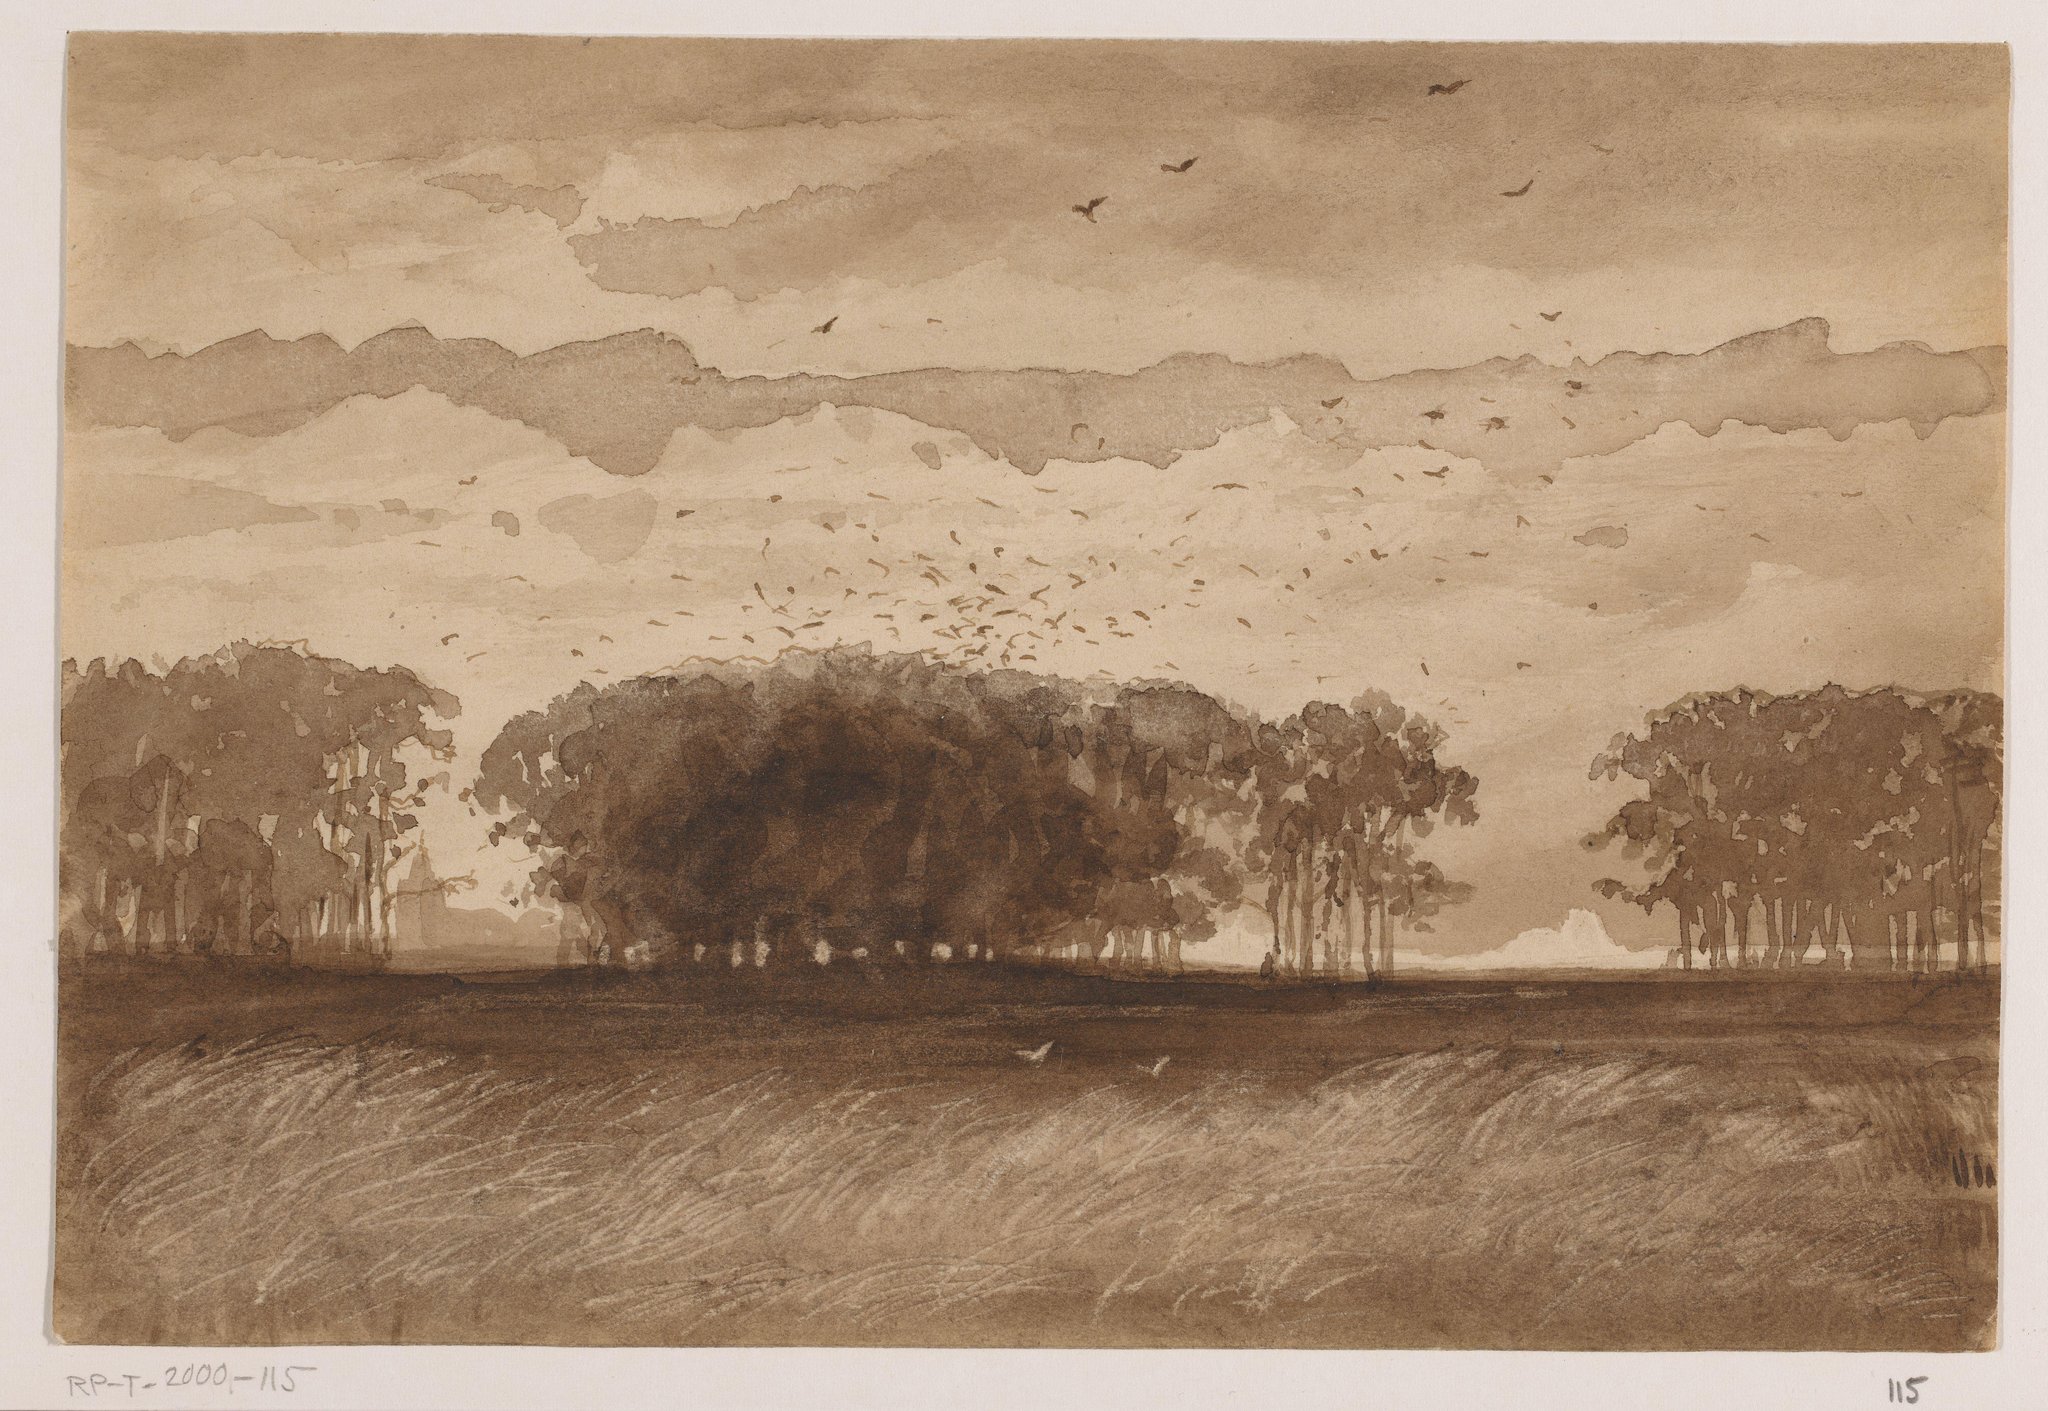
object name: drawing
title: Roekenkolonie in Noord-Brabant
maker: johannes tavenraat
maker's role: draughtsman, painter, print maker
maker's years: 1809-1881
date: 1842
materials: ink, paper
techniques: brush, pen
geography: ardennen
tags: song-birds: rook, groups of trees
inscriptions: annotation: ‘a Rookery on moorgroungs in North Brabant - Antwerp - 1842 - Tavenraat’, collector's mark: Lugt 2228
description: Landschap met een roekenkolonie boven bomen, in Noord-Brabant.